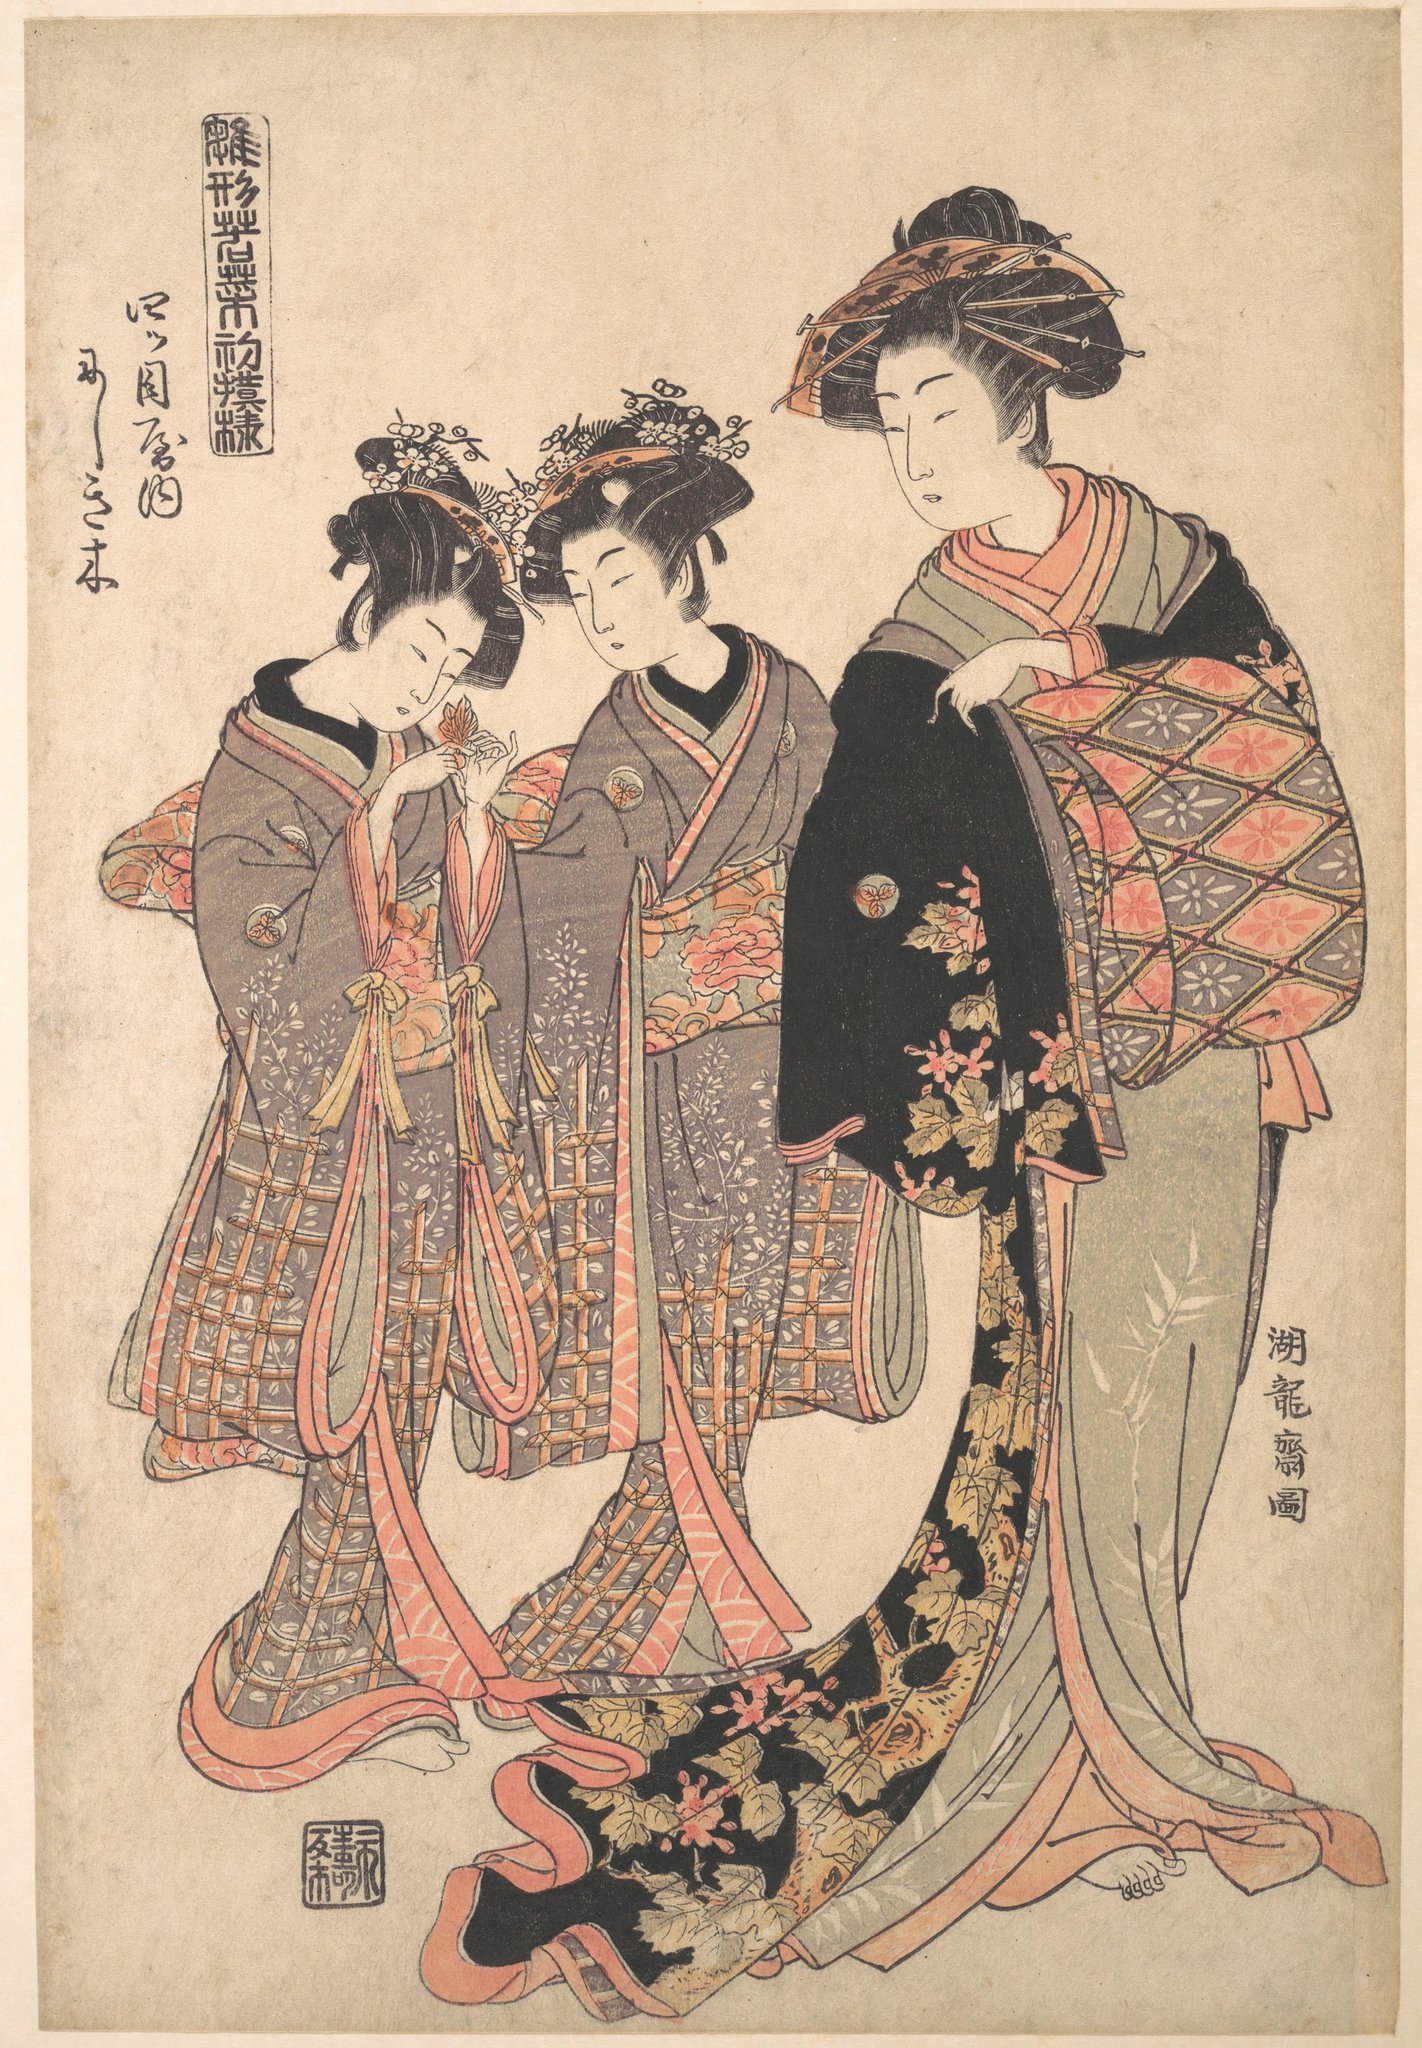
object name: print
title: The Courtesan Nishikigi of the Yotsumeya Brothel, from the series “A Pattern Book of the Year’s First Designs, Fresh as Spring Herbs” (“Hinagata wakana hatsu moyō”)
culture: japanese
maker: isoda koryūsai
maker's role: artist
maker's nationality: japanese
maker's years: 1735-1790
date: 1776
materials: ink, paper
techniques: woodblock print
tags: women